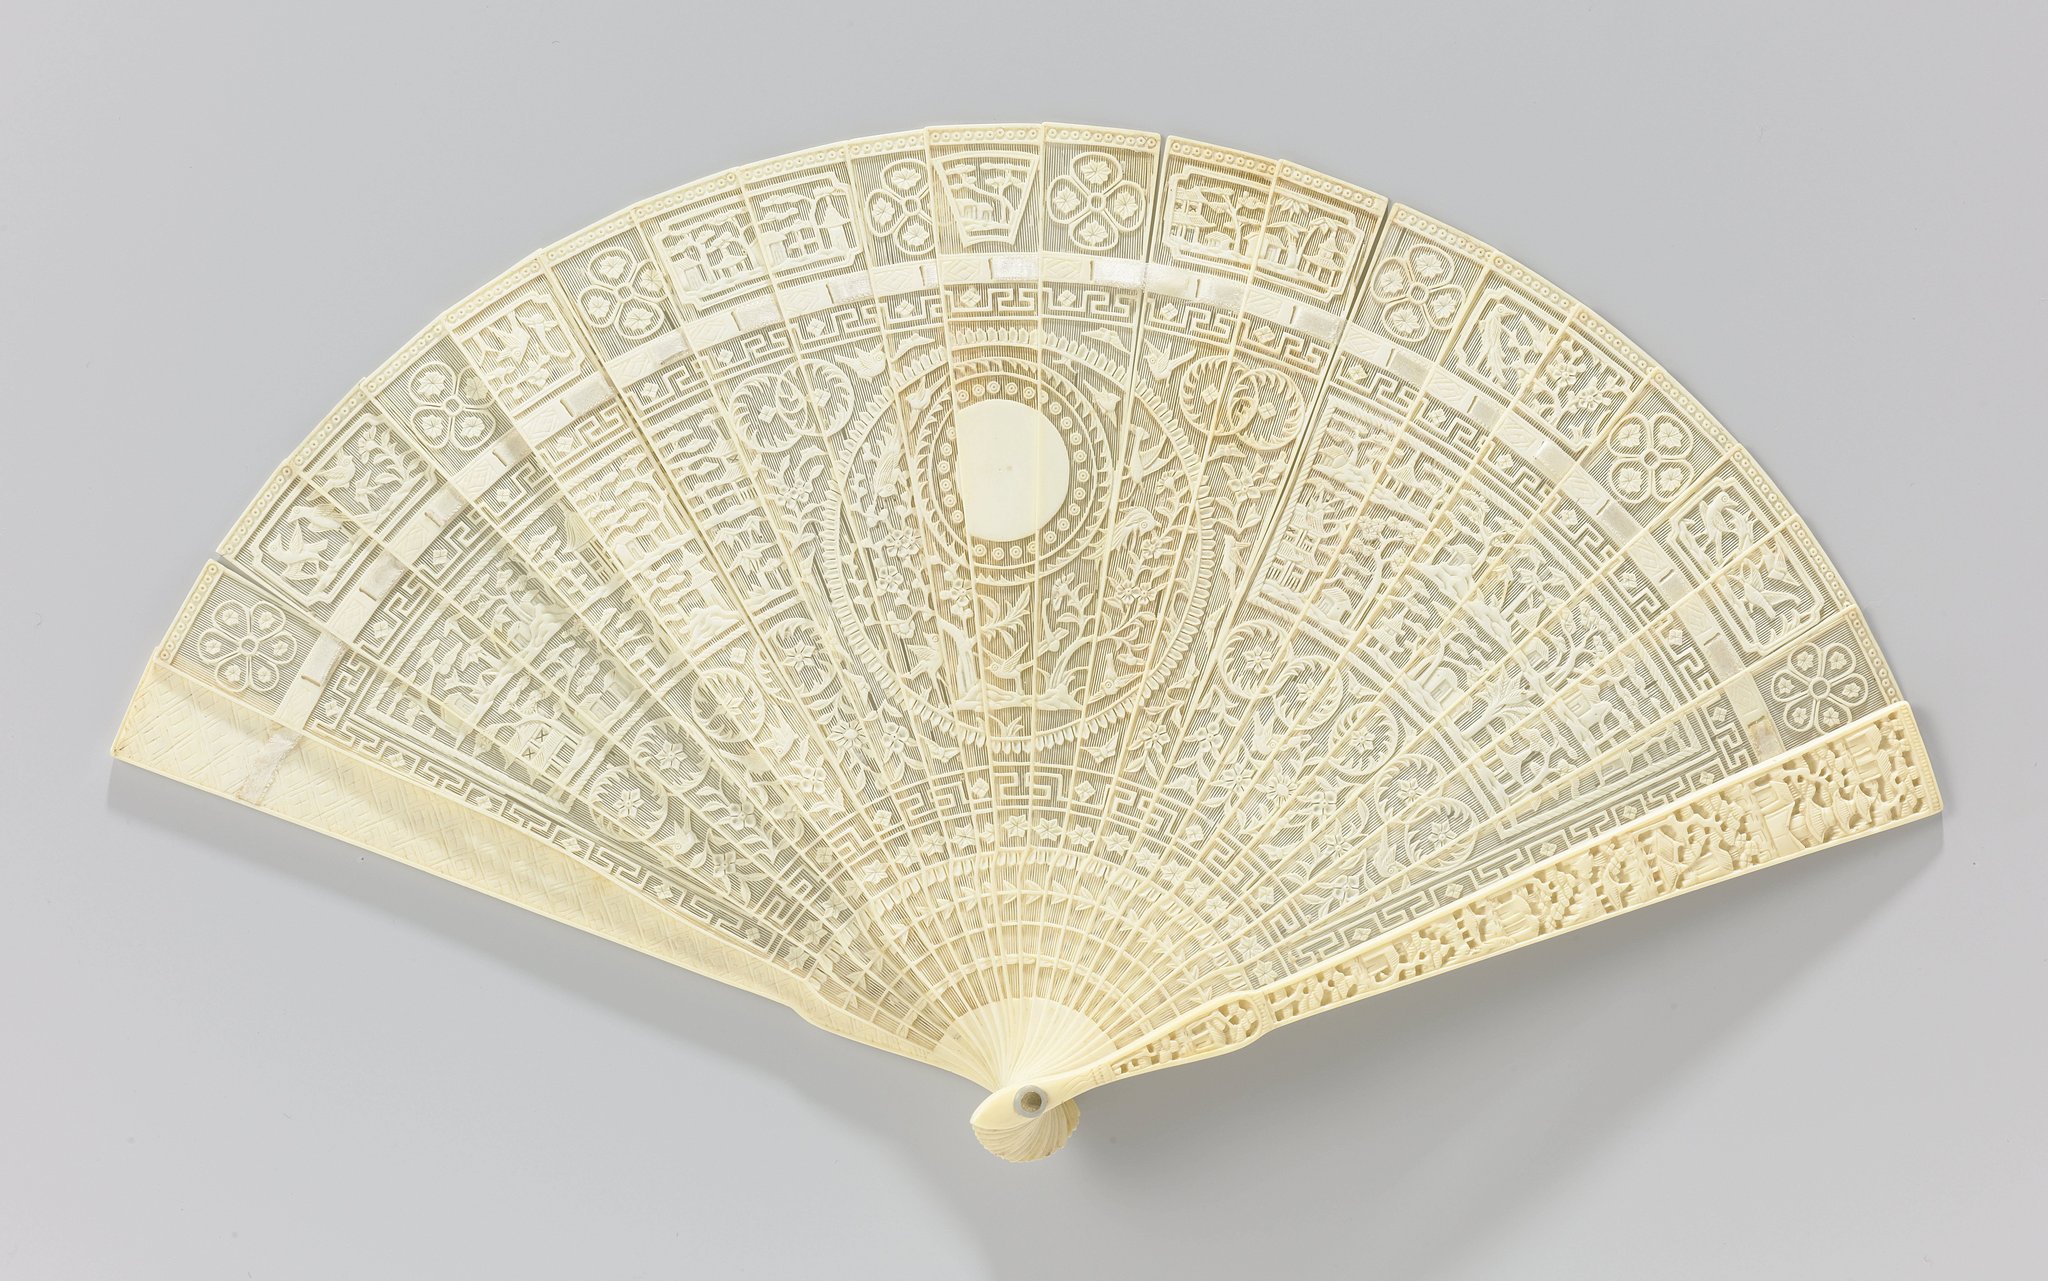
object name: brisé fan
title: Brisé-waaier van ivoor, gedritst en in ajour en reliëf gesneden benen waarop een Chinees landschap, bergen, paviljoens, vogels en een onversierd medaillon in het midden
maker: Anonymous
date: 1800-1820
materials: copper, ivory, mother of pearl, textile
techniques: cutting, embroidery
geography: hong kong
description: De ivoren brisé-waaier is gedritst en met in ajour en in reliëf gesneden een Chinees landschap, bergen, paviljoens, vogels en bloemmotieven. Centraal op de waaier is een onbewerkte medaillon. De achterkant van de waaier is onversierd. De 22 aaneengesloten benen worden bijeengehouden door een geregen lintje. Bij de sluitpin een parelmoeren schijfje.